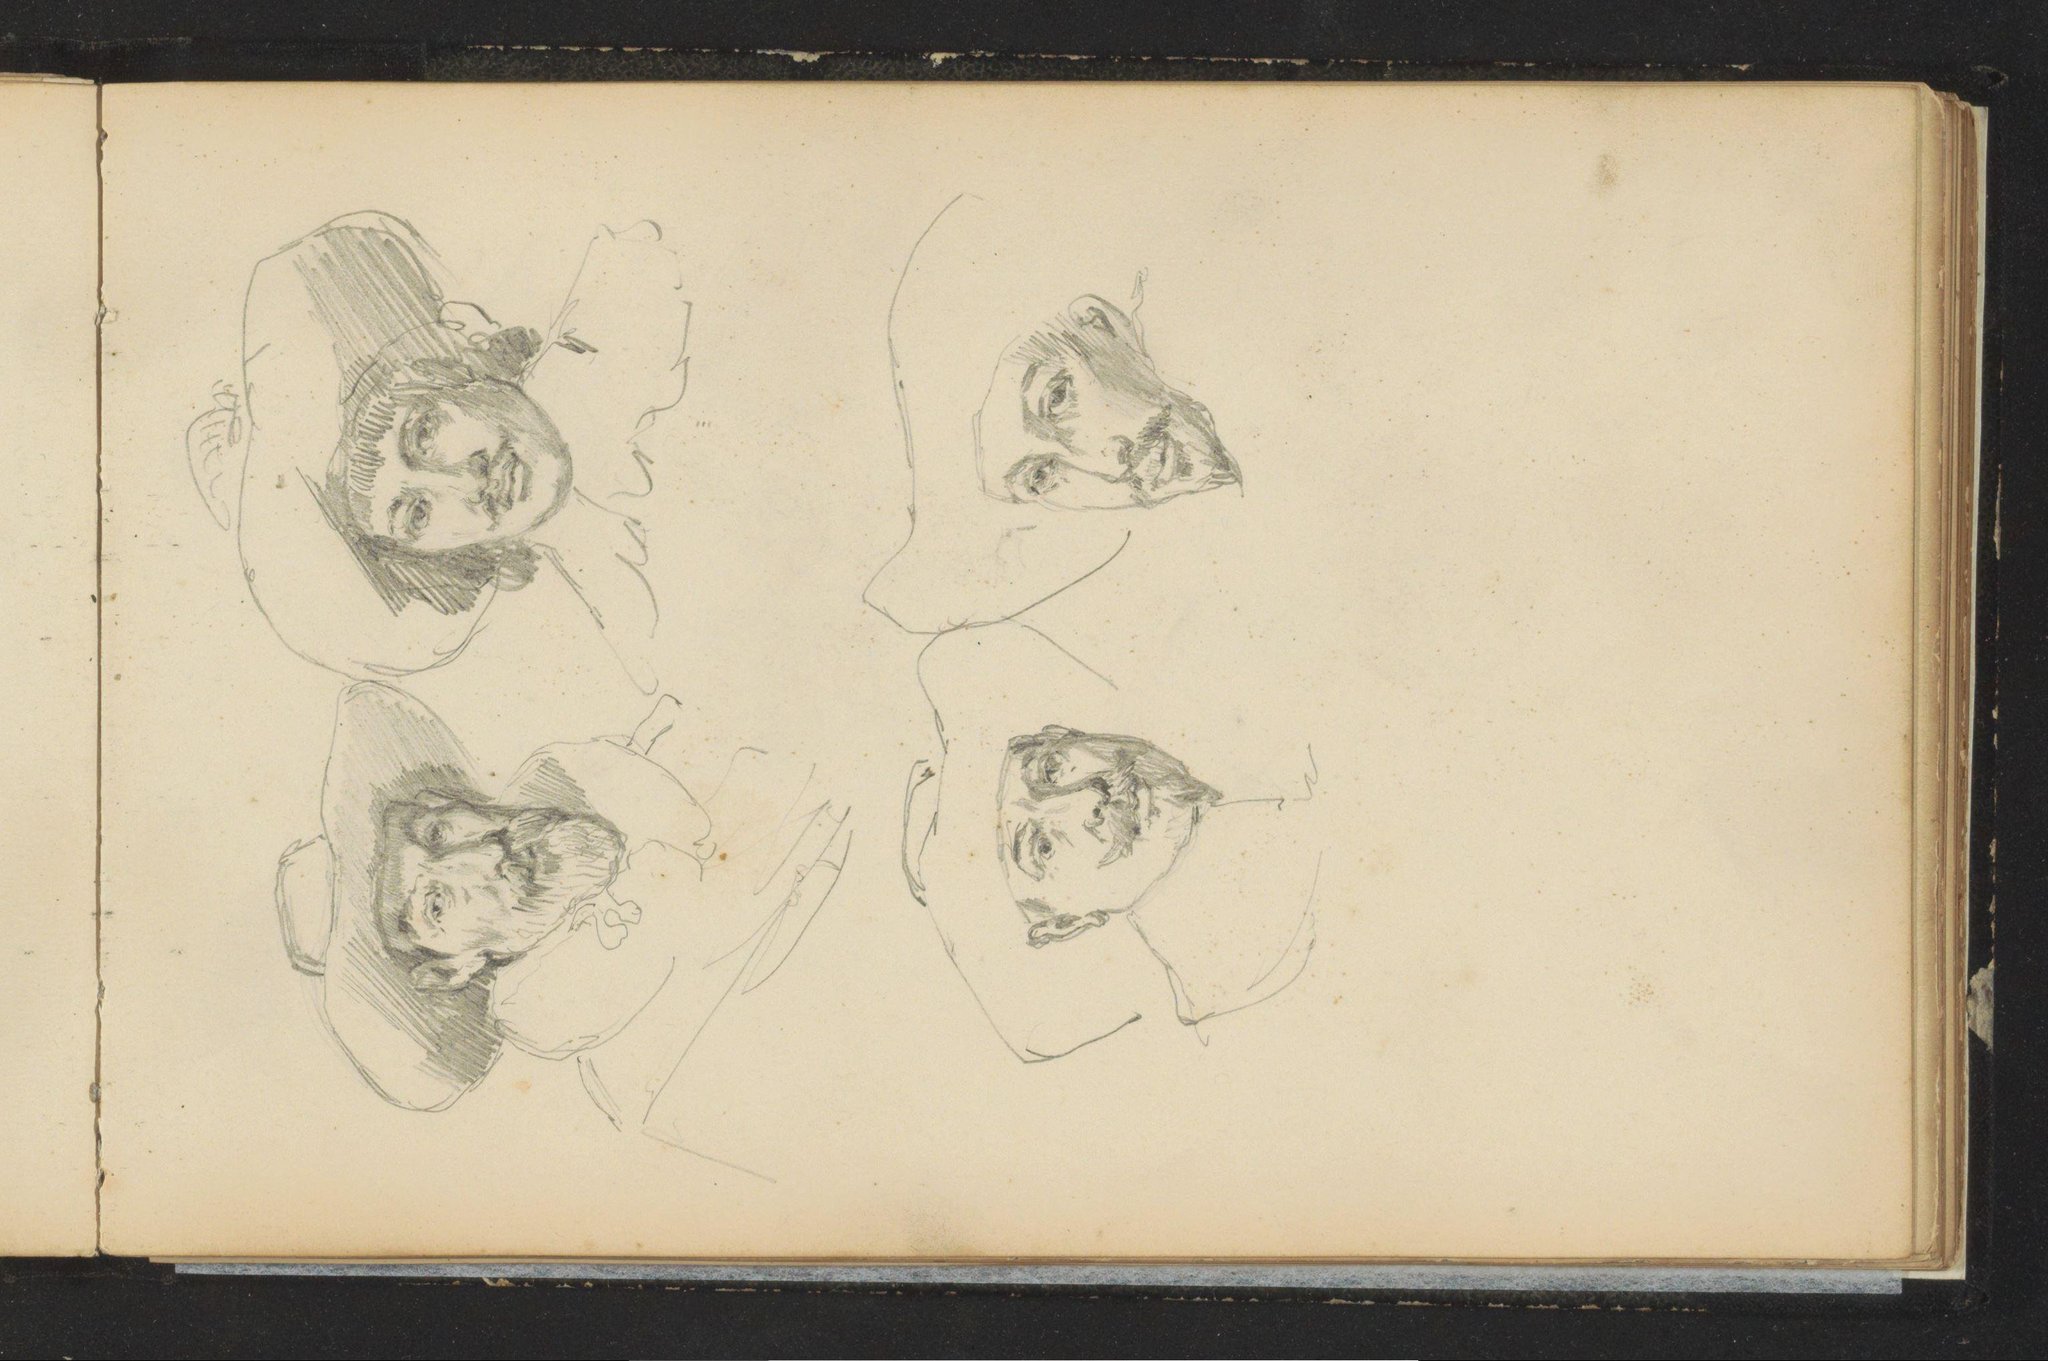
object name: sketchbook leaf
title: Vier mannenhoofden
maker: cornelis springer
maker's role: draughtsman, painter, print maker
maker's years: 1817-1891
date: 1846-1882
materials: paper, pencil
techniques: stumping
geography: netherlands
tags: neck-gear ~ clothing (with name), adult man, head-gear: hat (+ men's clothes), clothes, costume (+ men's clothes)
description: Vier mannenhoofden met hoeden. De man linksboven draagt een plooikraag. Blad 49 uit een schetsboek met 91 bladen.